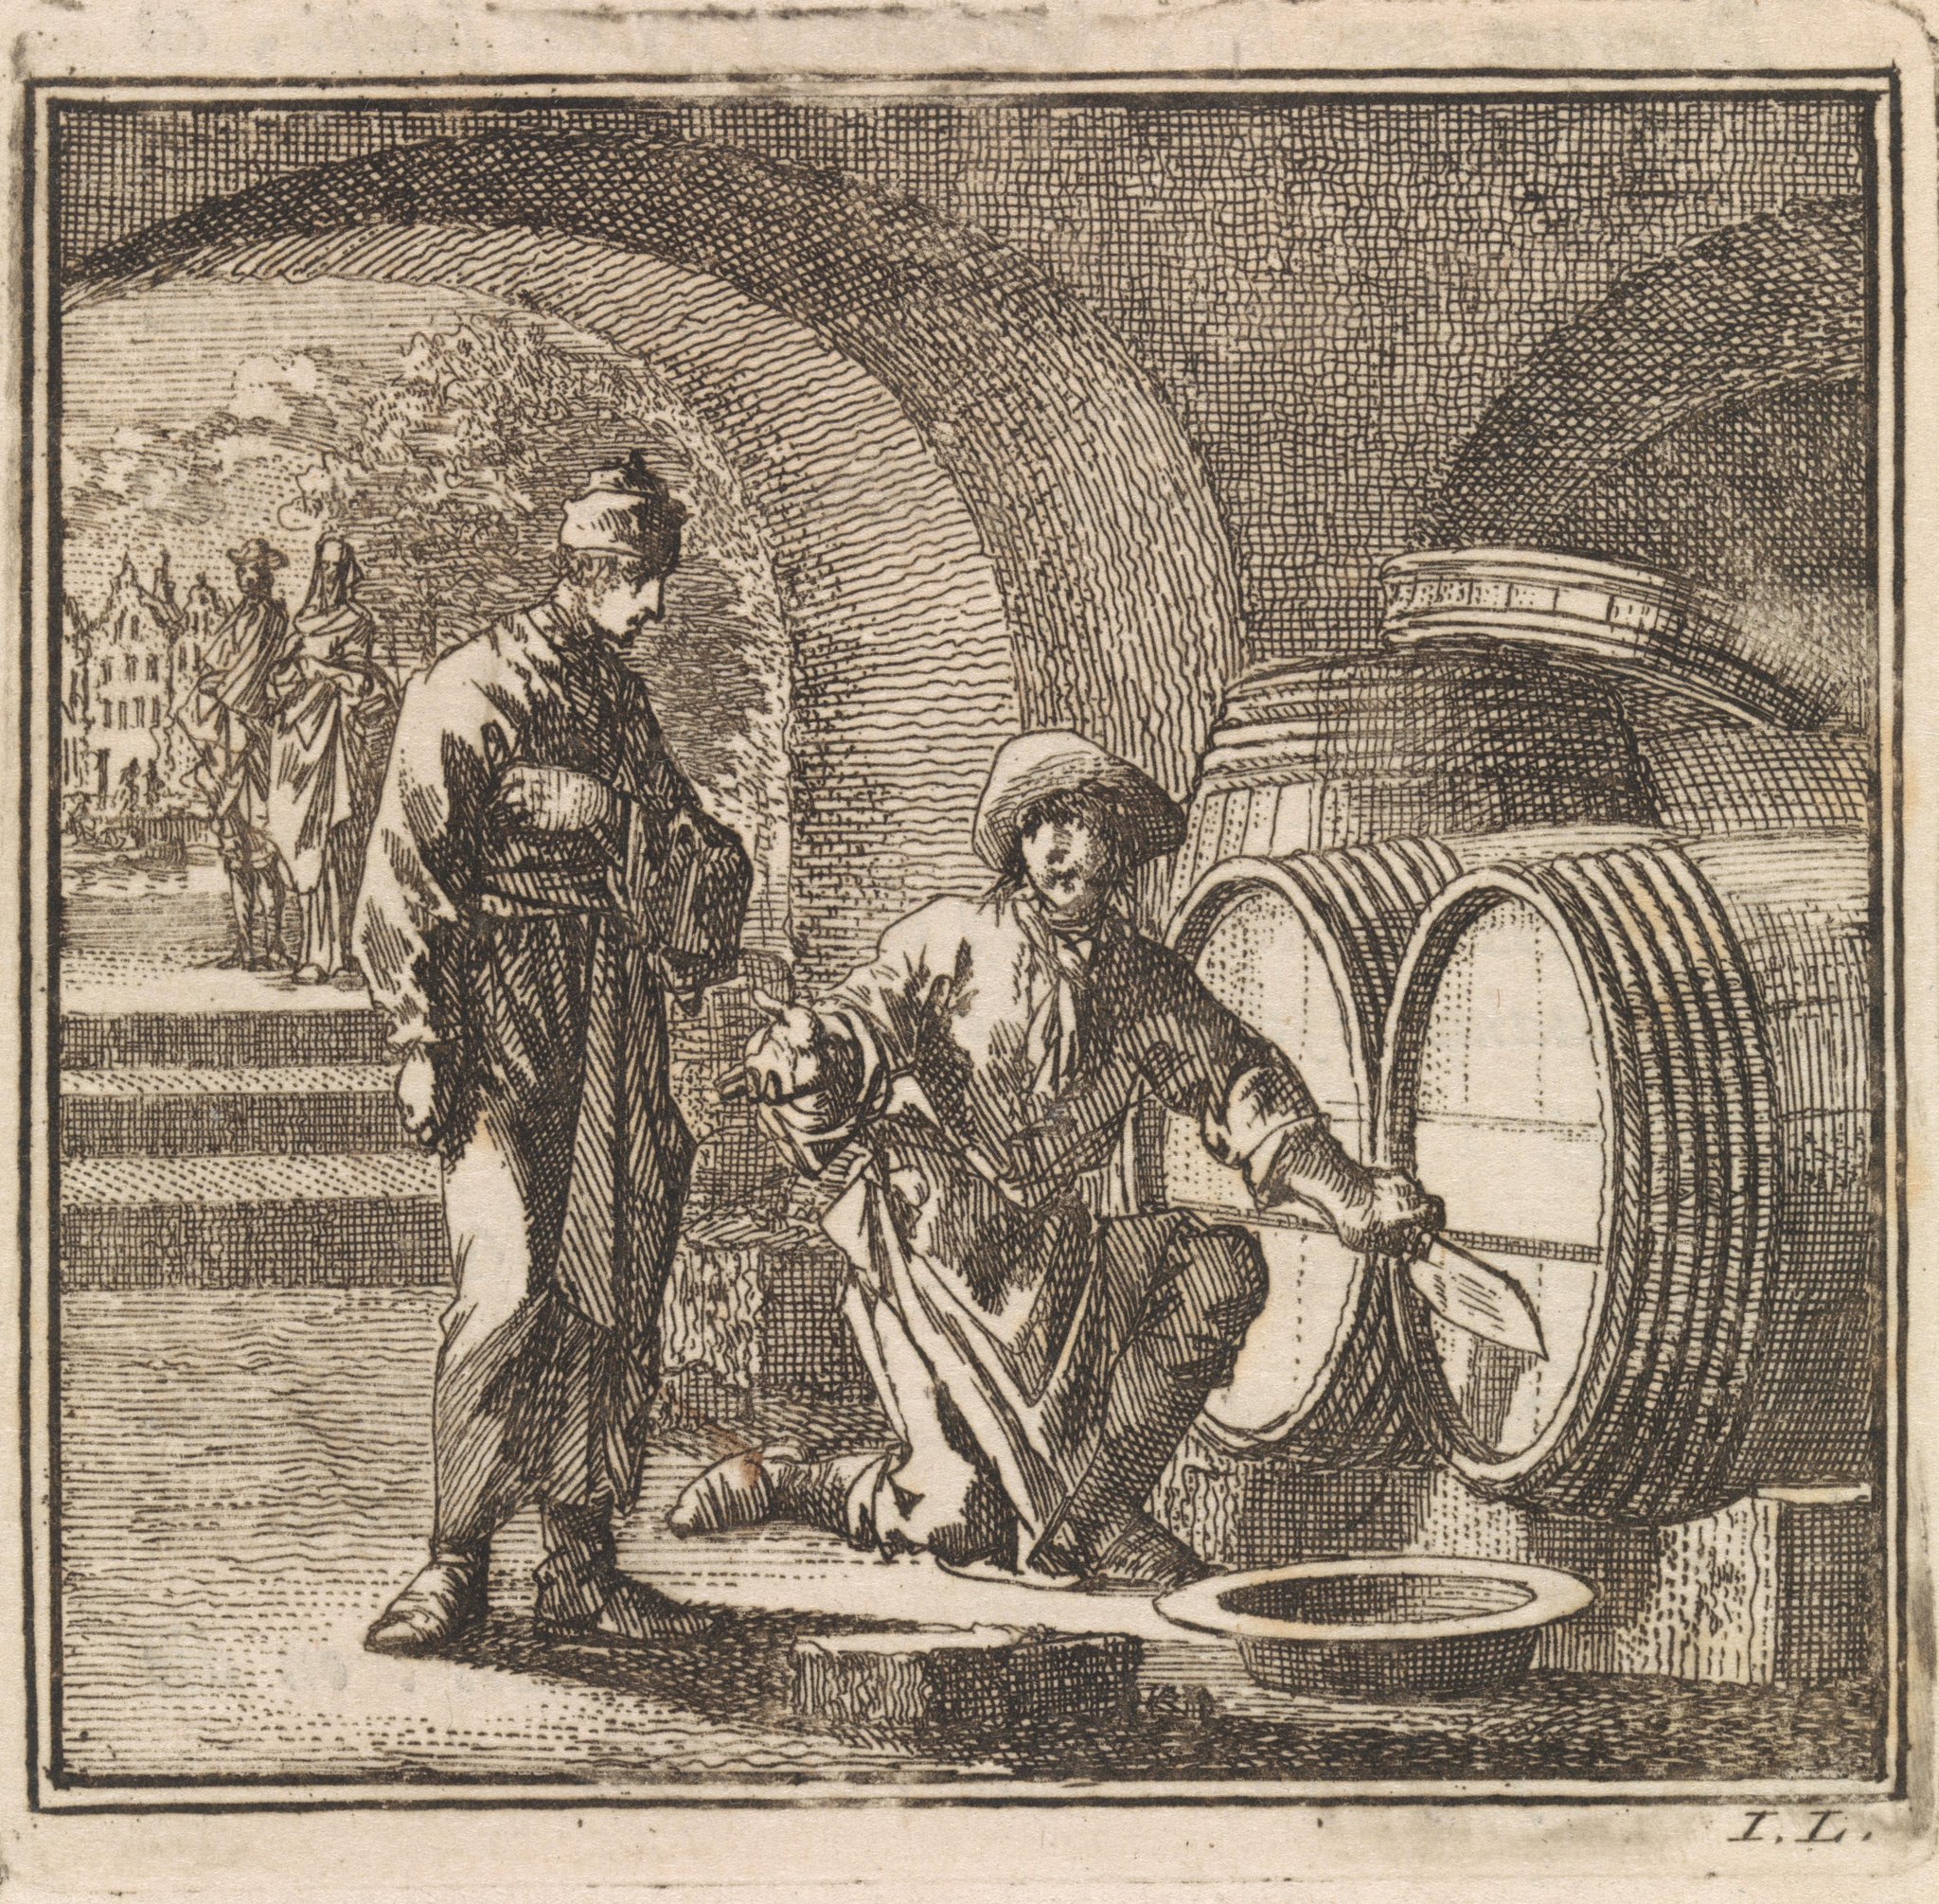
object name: book illustration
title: Twee mannen bij een wijnvat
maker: jan luyken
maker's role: draughtsman, print maker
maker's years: 1649-1712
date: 1711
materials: paper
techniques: etching, letterpress printing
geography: amsterdam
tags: wine-cellar, wooden container: barrel, cask, bucket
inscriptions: collector's mark: Lugt 2228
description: Illustratie voor: Luyken, Jan. De Bykorf des Gemoeds. Amsterdam: Pieter Arentsz. II (wed.) en Cornelis van der Sys, 1711, p. 298.